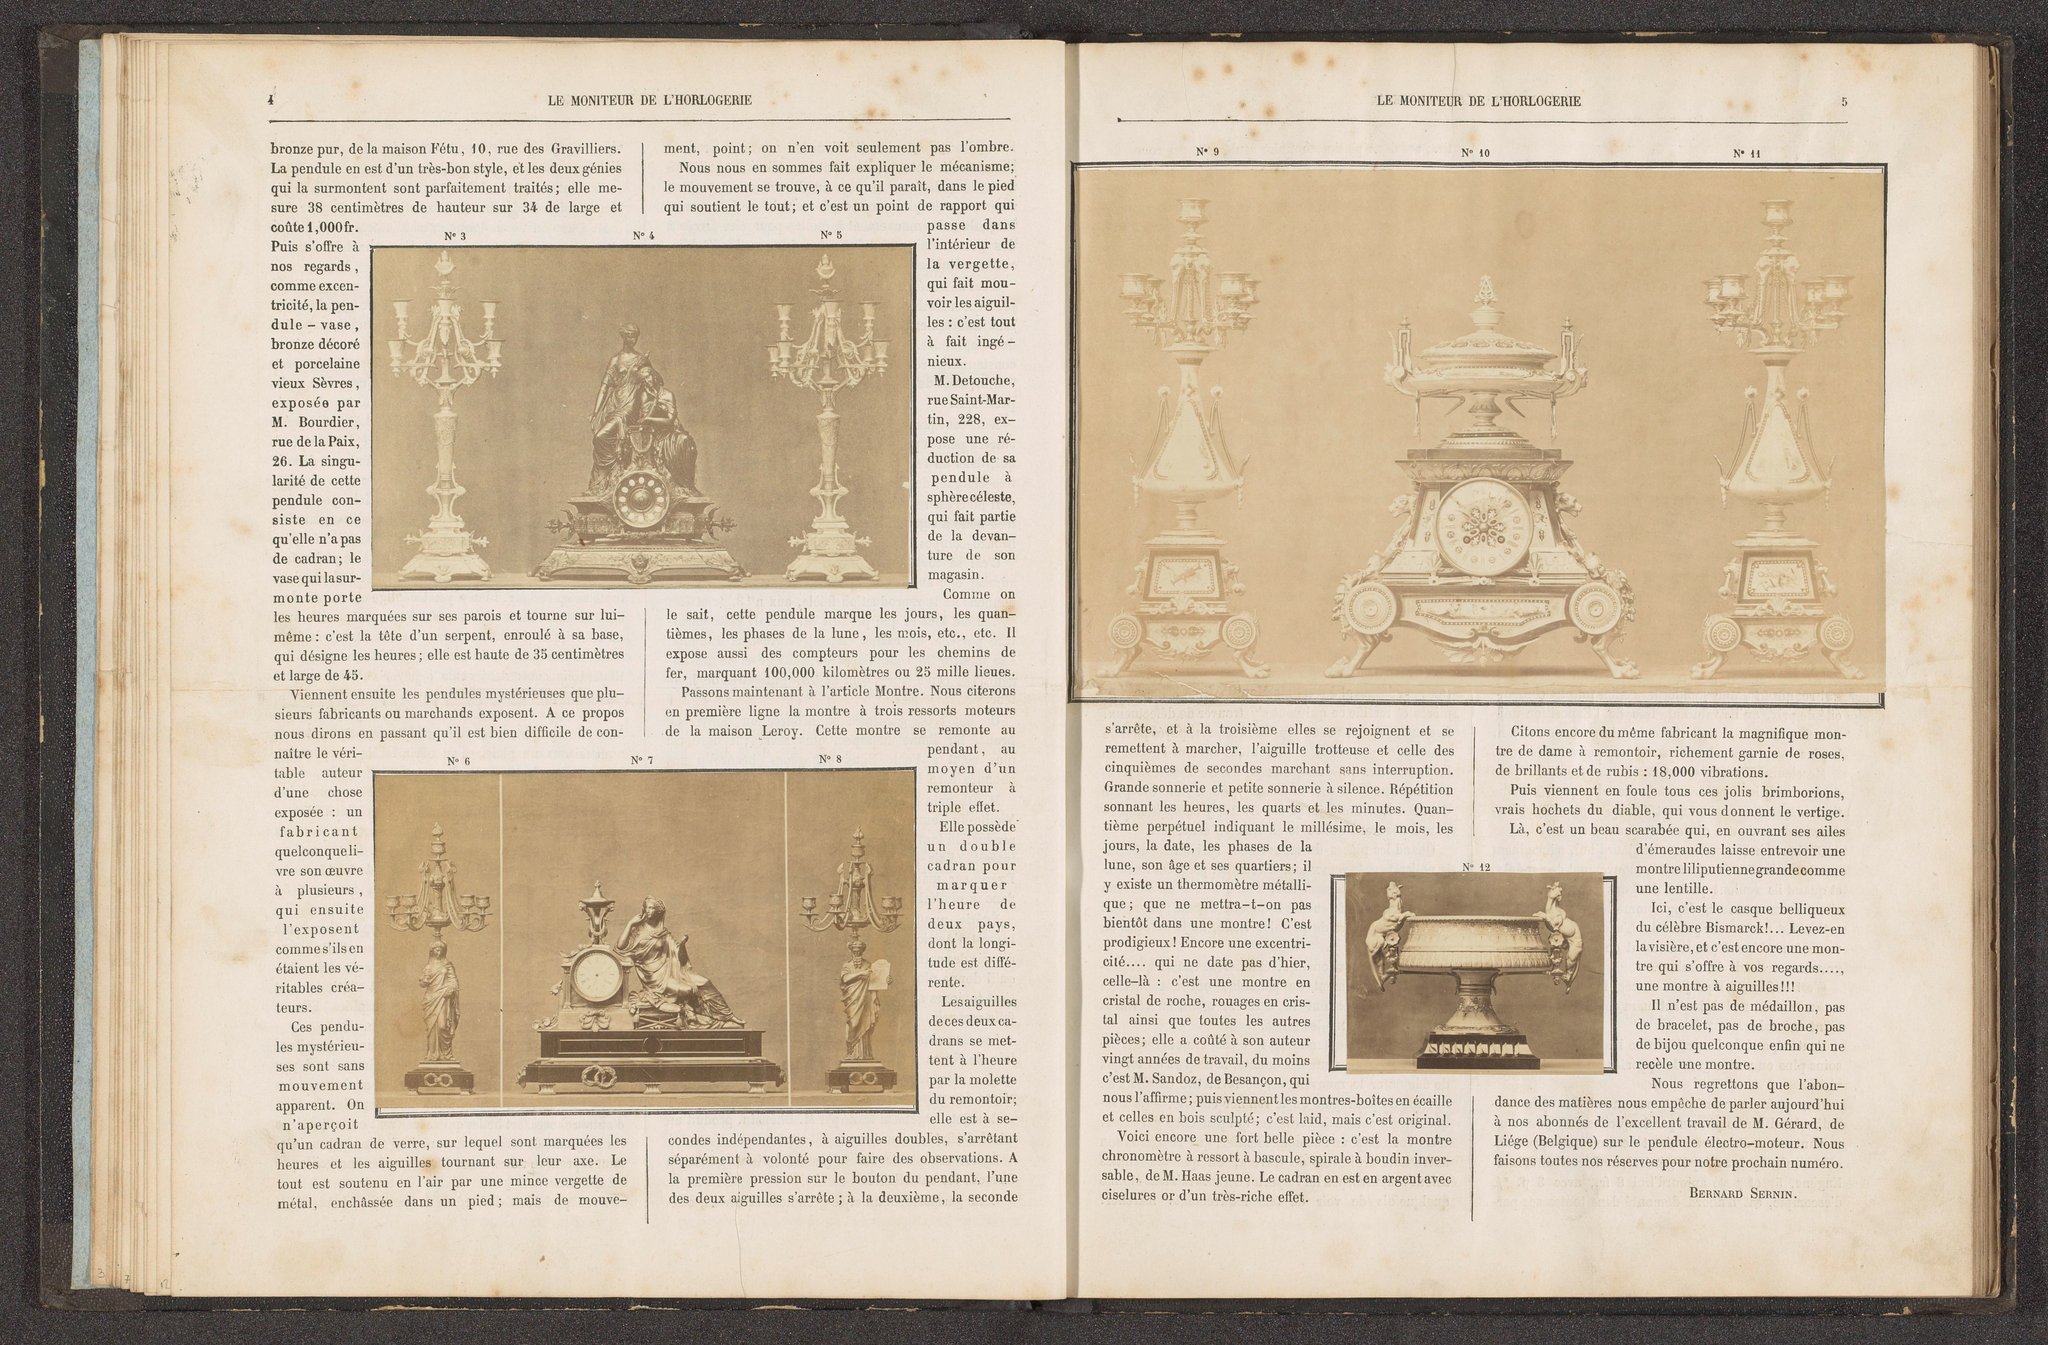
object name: page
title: Twee afbeeldingen van een klok met twee kandelaren ernaast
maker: Anonymous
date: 1857-1867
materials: photographic support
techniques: albumen print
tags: clock, candlestick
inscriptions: number: ‘No 3 No 4 No 5 No 6 No 7 No 8’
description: Boven: klok gedecoreerd met twee vrouwen door M. Duval, onder: klok gedecoreerd met een zittende vrouw door M. Dhénain.